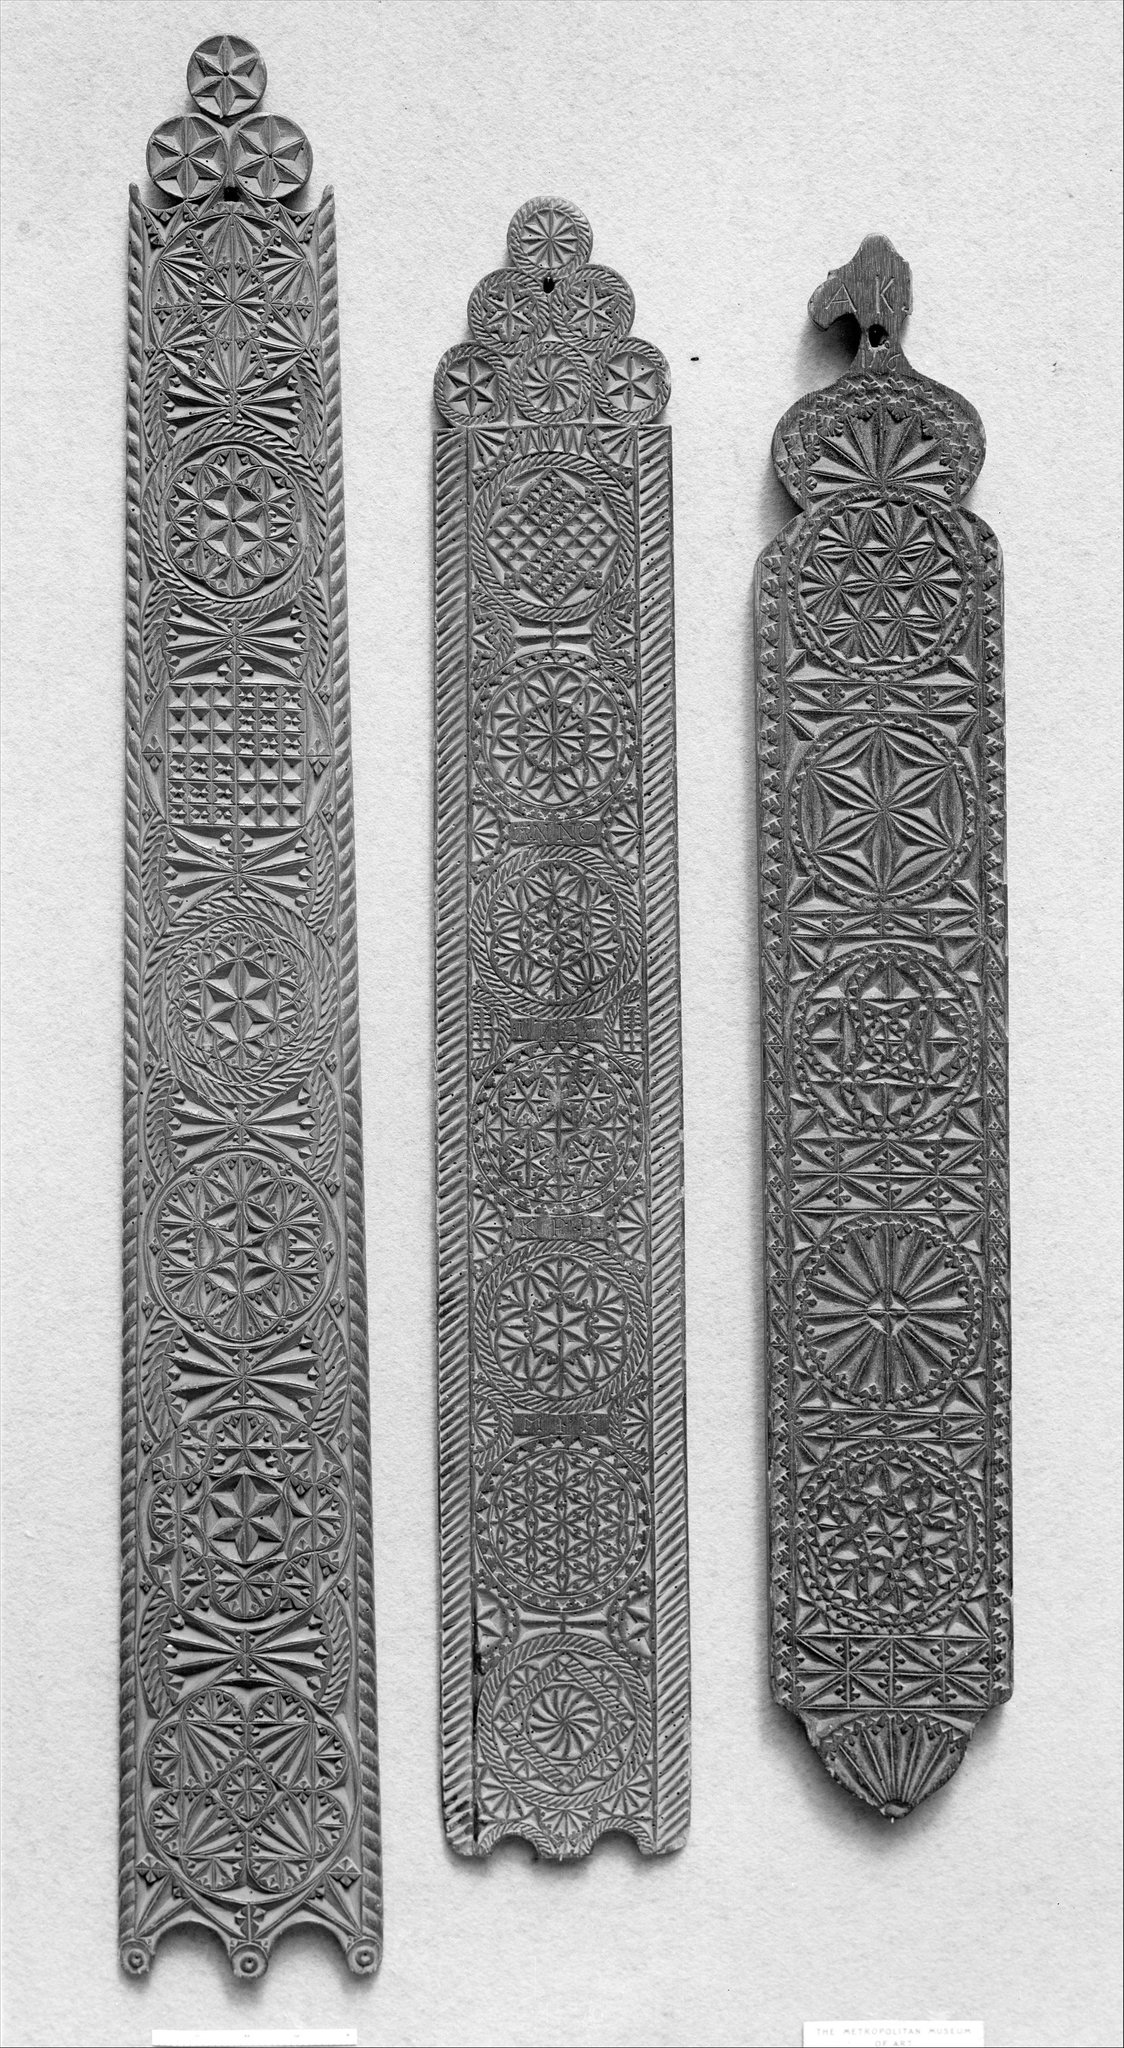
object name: mangle board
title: Mangle-board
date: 1776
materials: wood